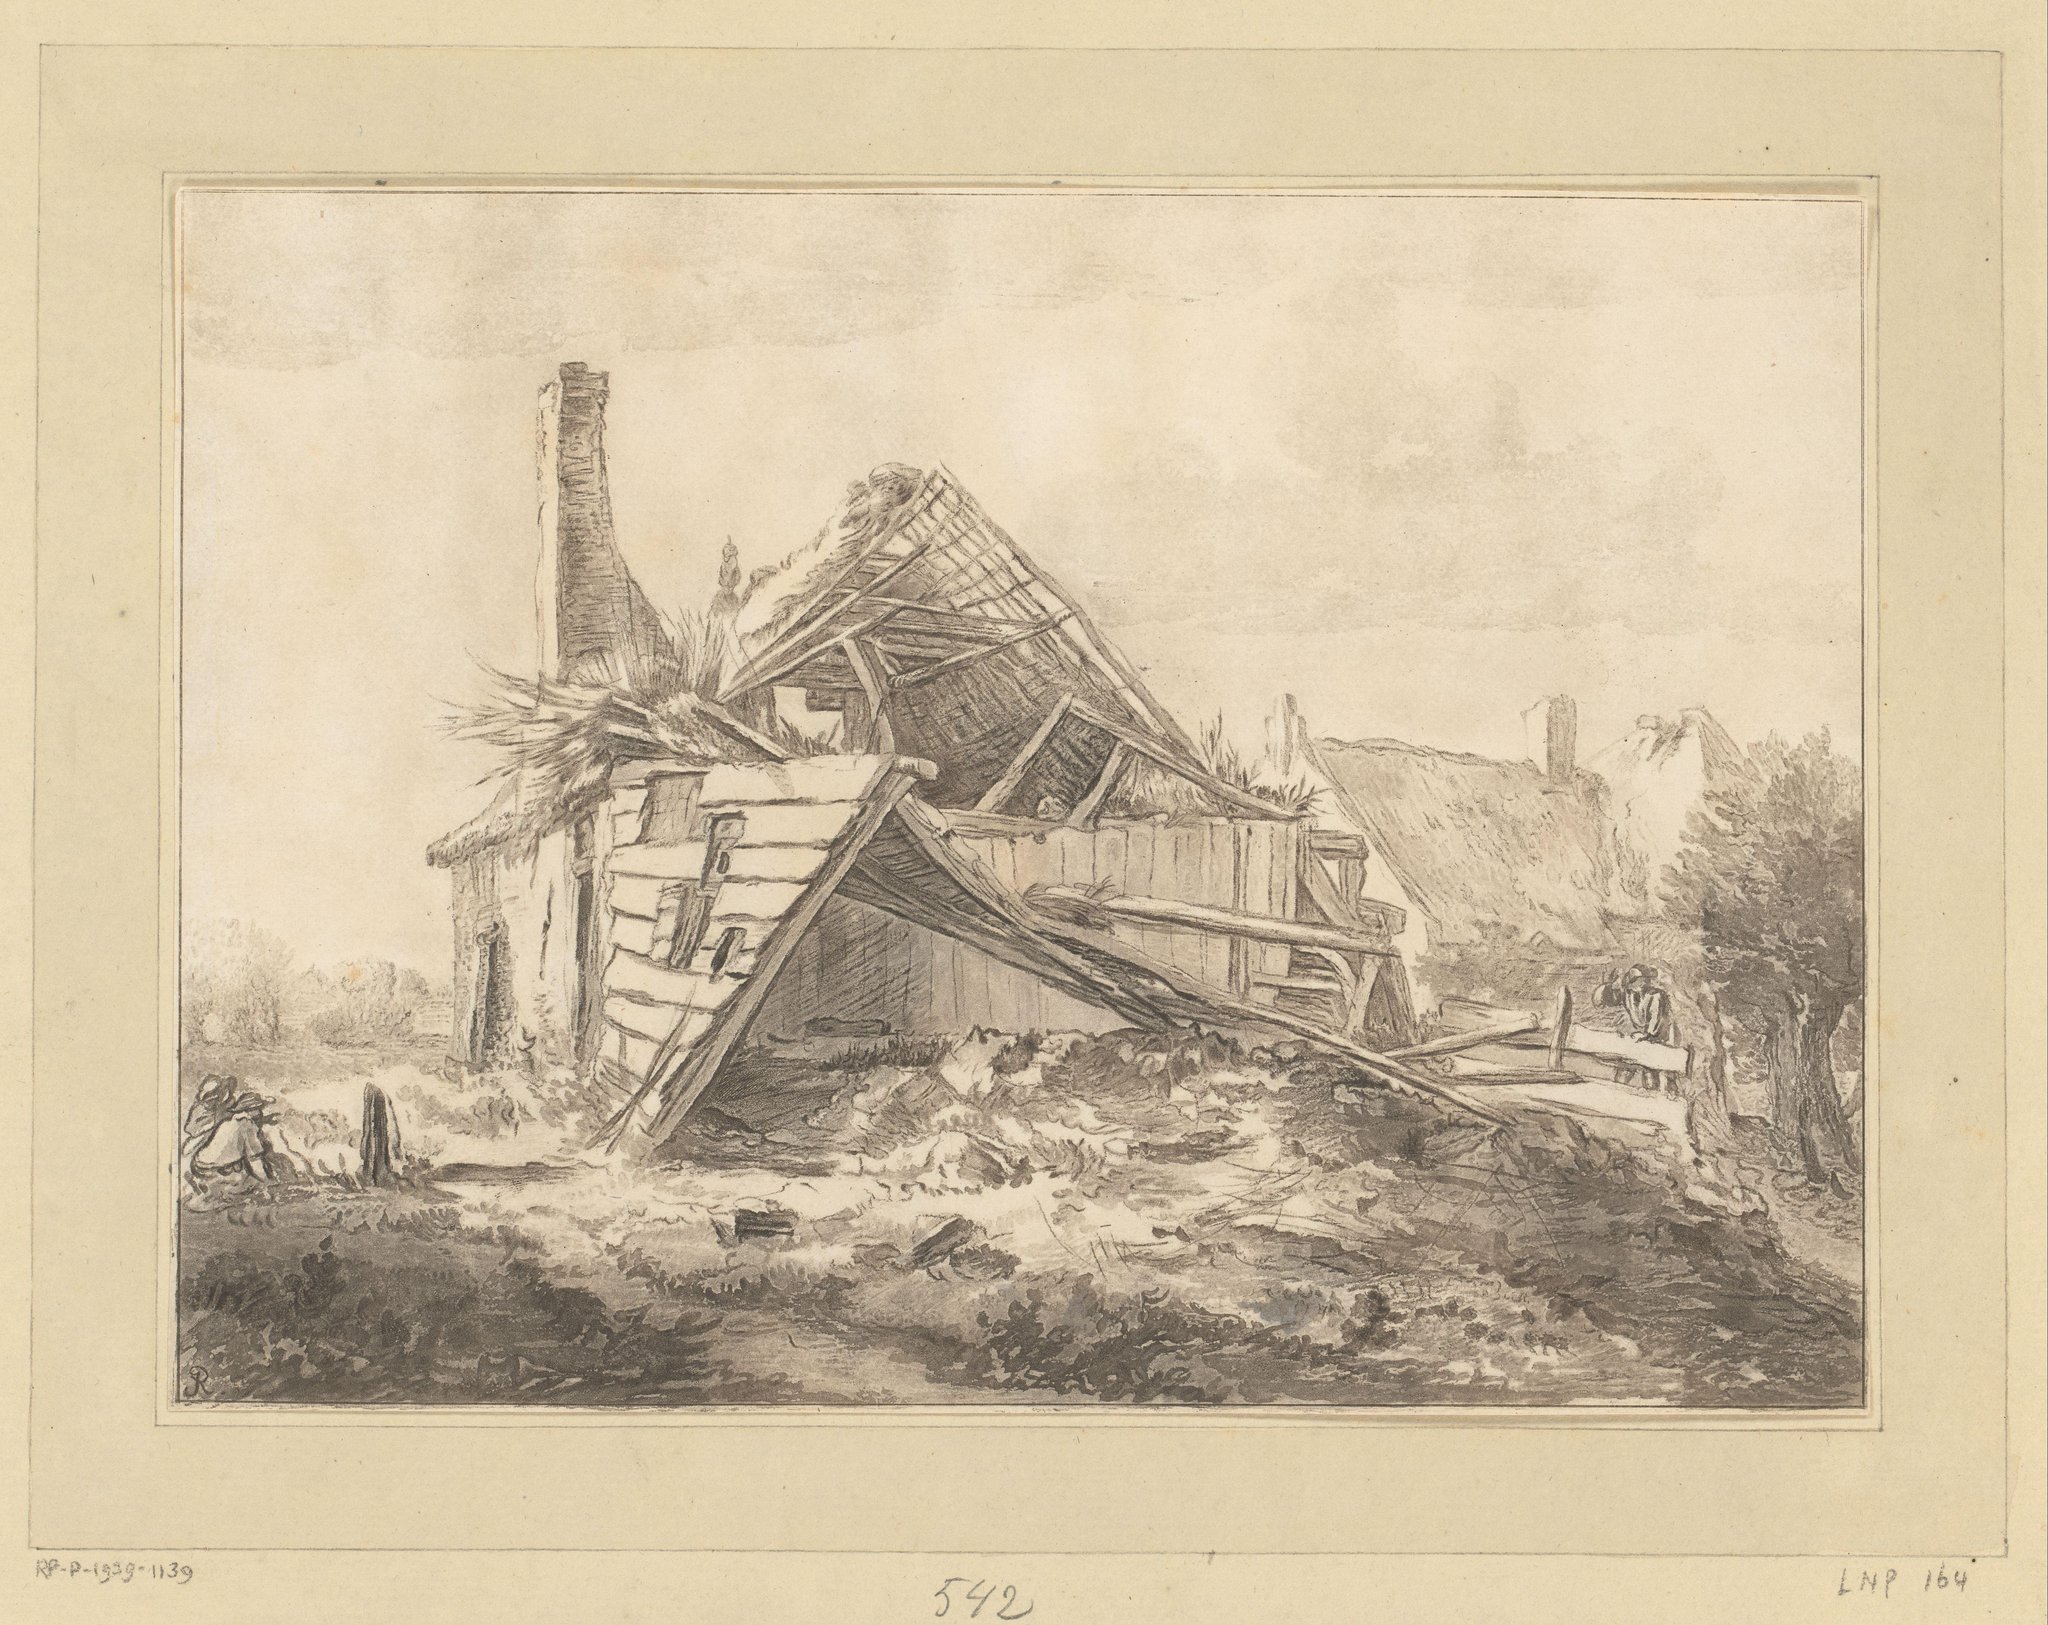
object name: print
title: Vervallen boerderij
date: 1741-1803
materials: paper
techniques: printmaking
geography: amsterdam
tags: farm or solitary house in landscape, neglected dwelling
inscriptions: collector's mark: ‘RIJKS / MUSM’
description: Cornelis Brouwer heeft in samenwerking met C.S. Roos een aantal prenttekeningen uitgegeven welke op het verso het signatuur C.Brouwer fecit en C.S. Roos excudit Amst. dragen. De prent werd opgenomen in: Collection d'imitations de dessins d'après les principaux maîtres hollandais et flamands, Londen, C. Josi, 1821.